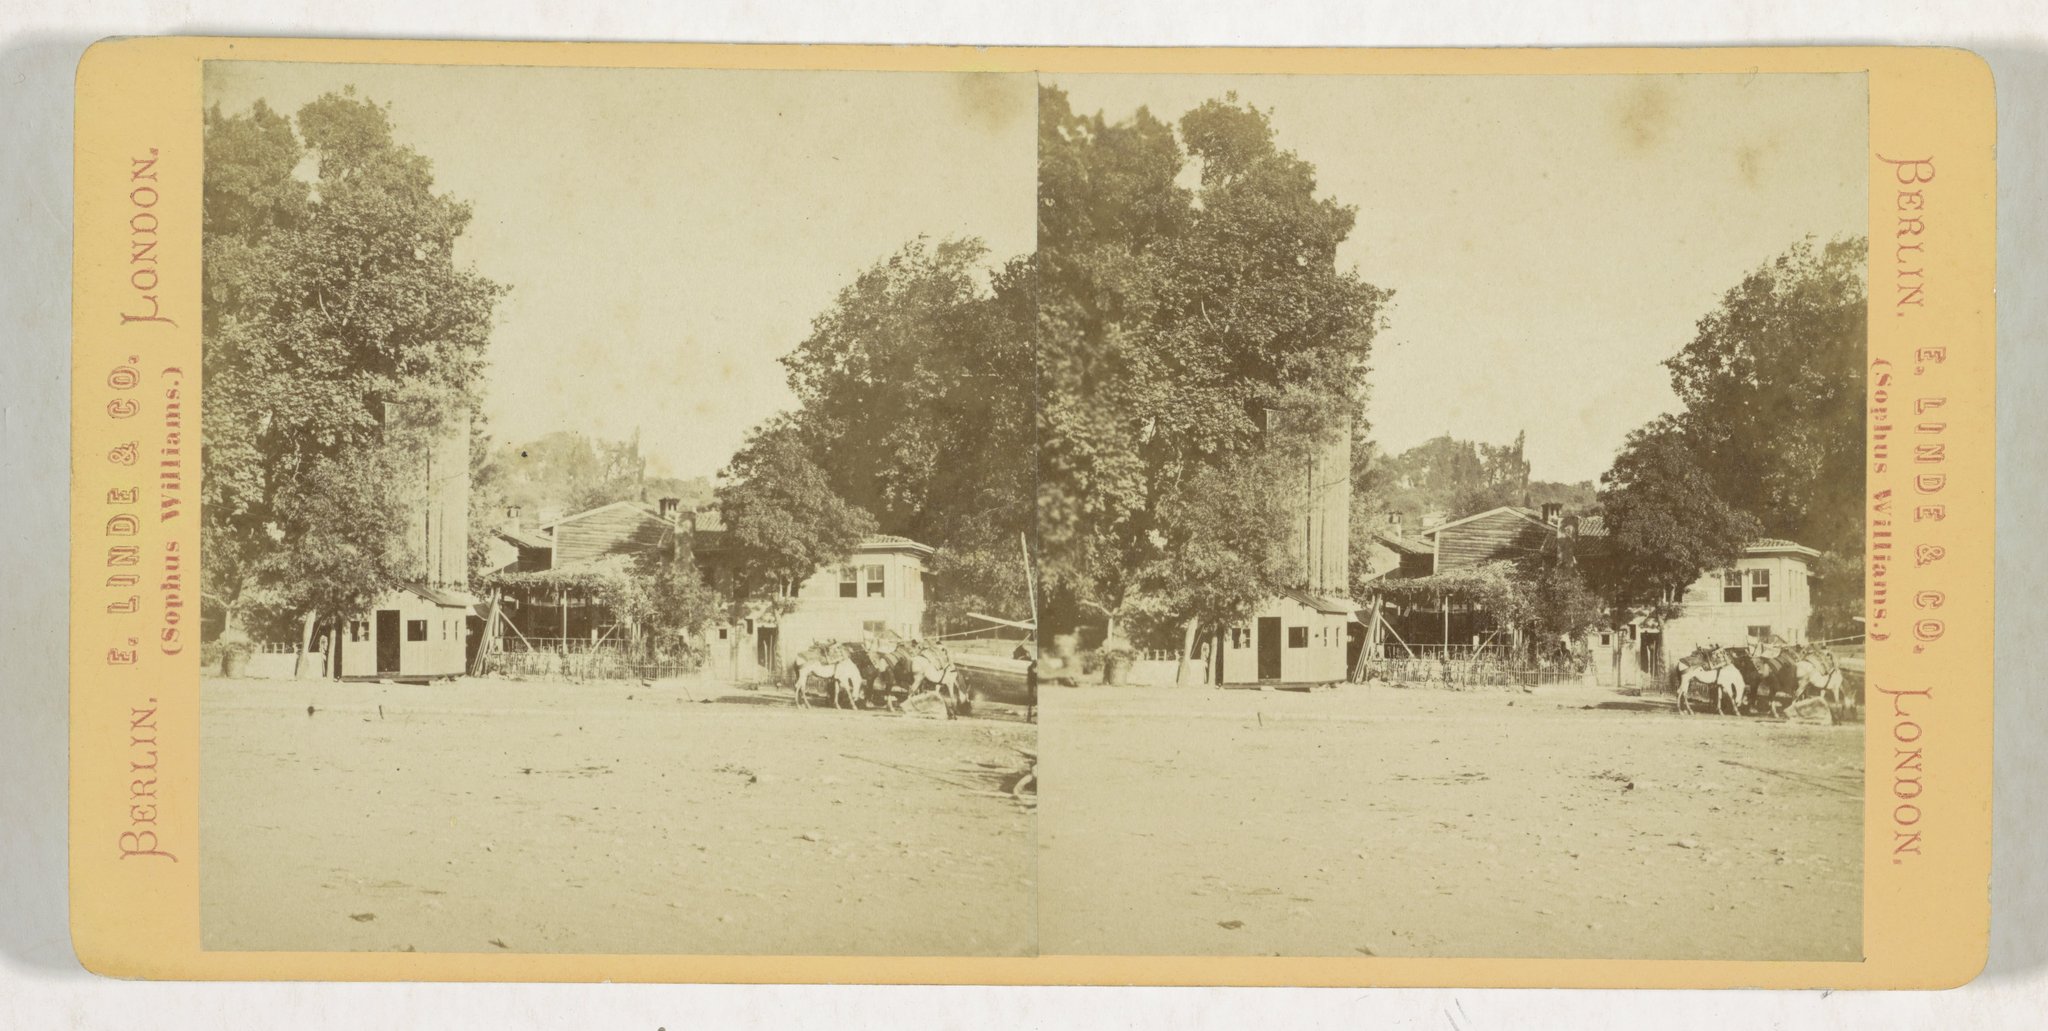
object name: stereograph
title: Beikos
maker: Anonymous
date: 1873-1890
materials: cardboard, paper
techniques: albumen print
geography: beykoz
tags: village